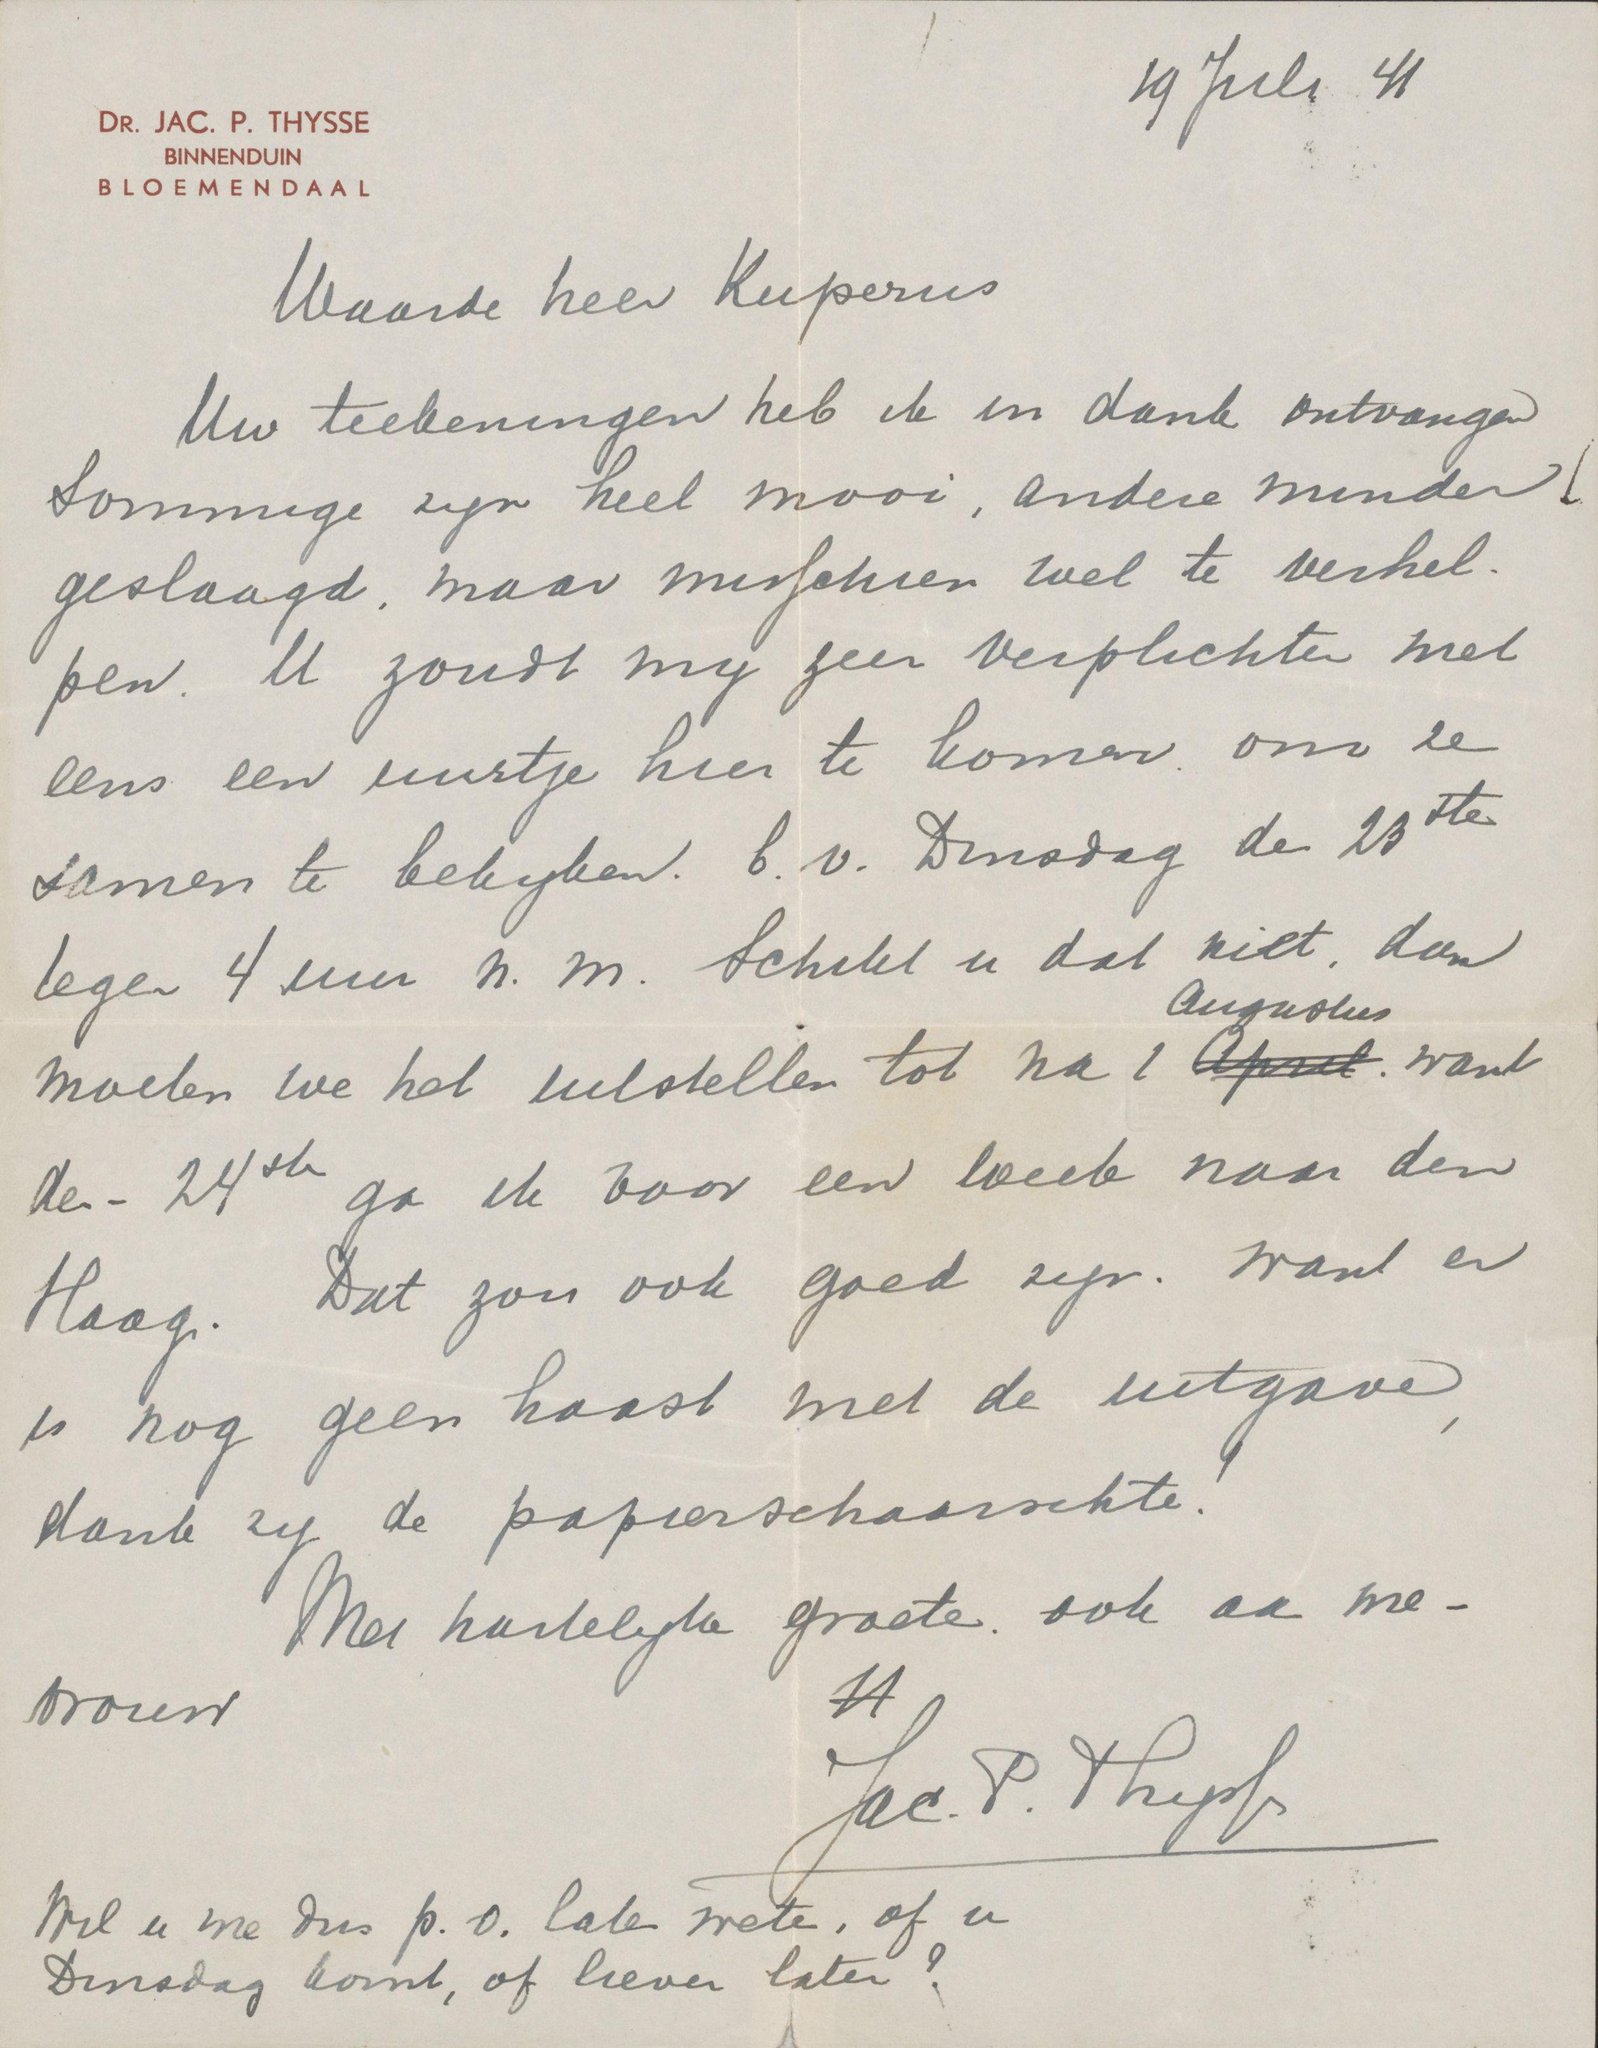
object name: letter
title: Brief aan Sjoerd Kuperus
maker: jac. p. thijsse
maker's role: bioloog, onderwijzer, schrijver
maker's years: 1865-1945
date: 1941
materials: ink, paper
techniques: pen, printing, writing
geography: bloemendaal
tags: print maker, draughtsman, sjoerd kuperus, illustration ~ printed matter, book, the hague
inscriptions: collector's mark: ‘RPK’, watermark